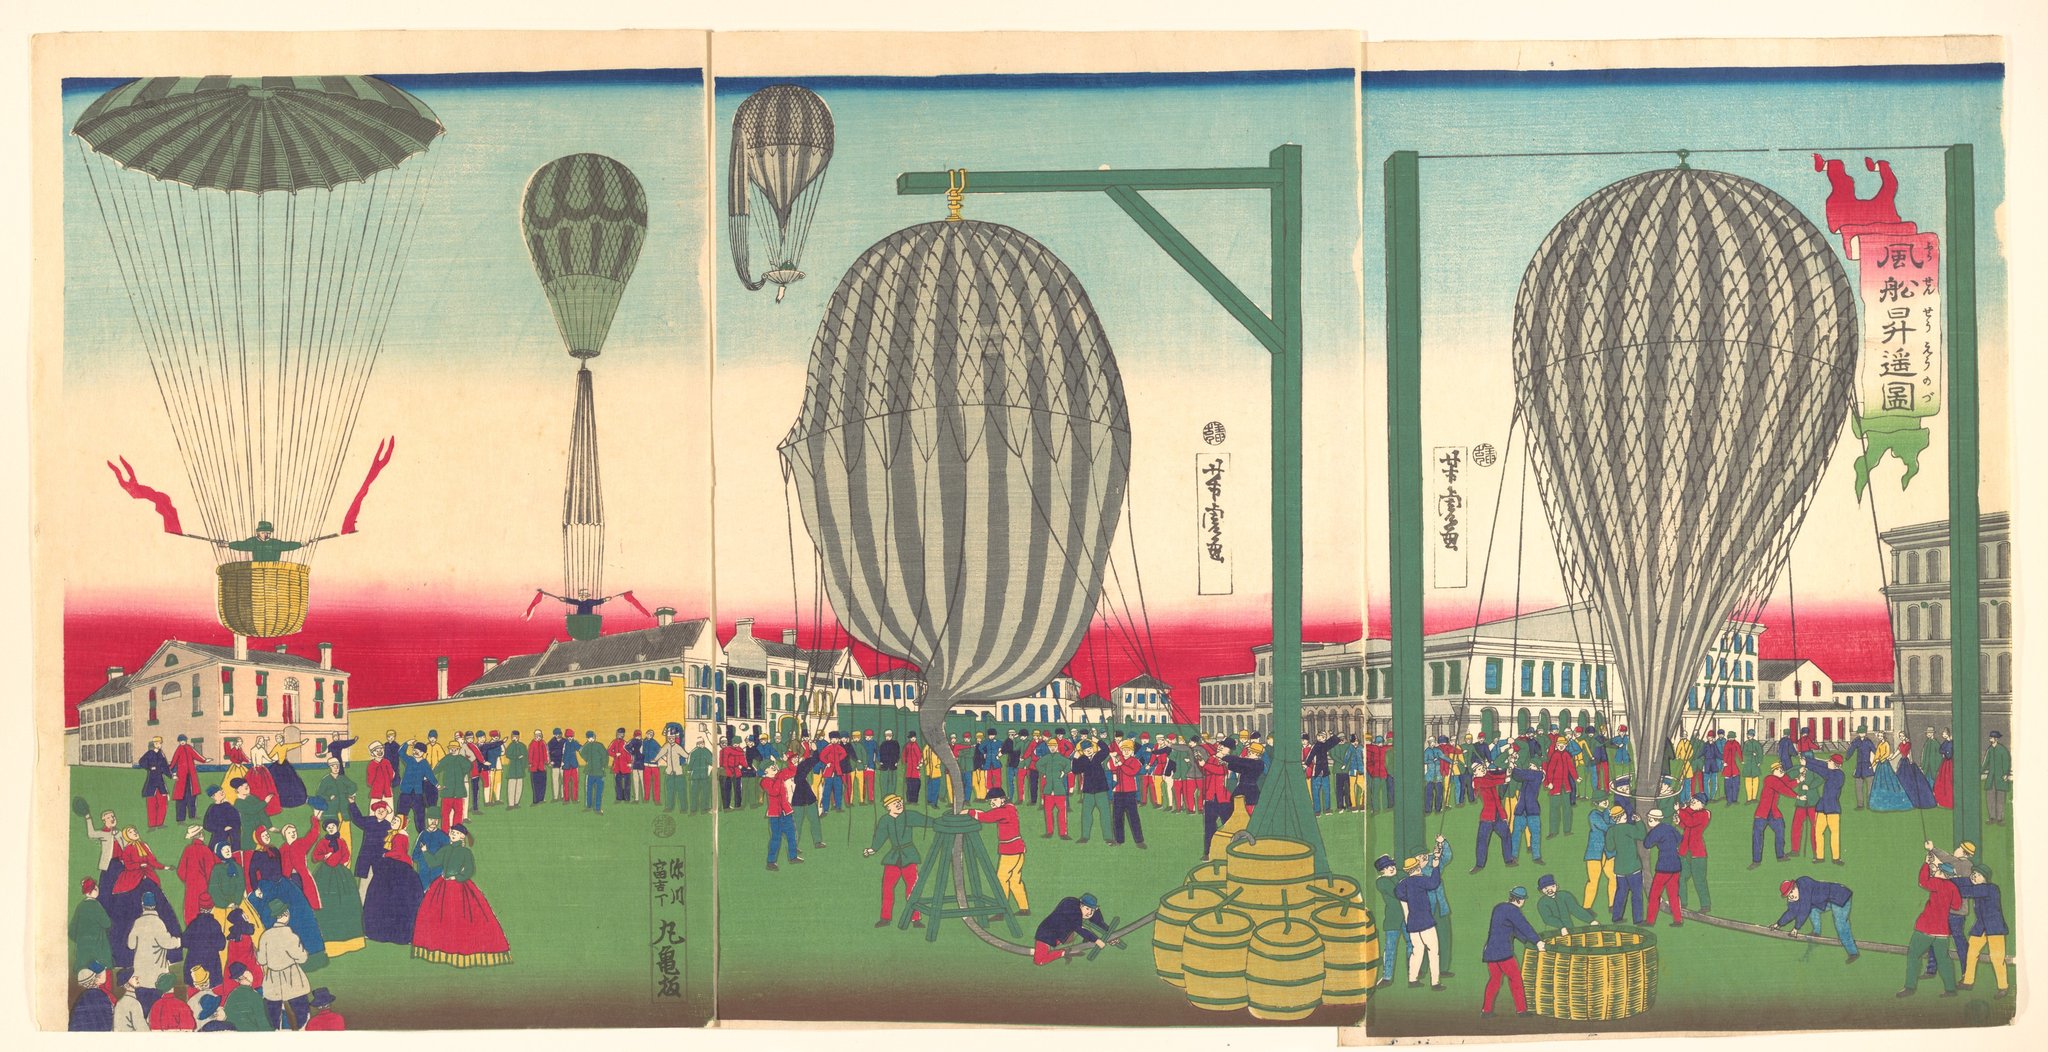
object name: print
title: Illustration of a Balloon Ascending (Fūsen shōyō no zu)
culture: japanese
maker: utagawa yoshitora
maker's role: artist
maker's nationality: japanese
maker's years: 1845-1880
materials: ink, paper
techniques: woodblock print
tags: crowd,hot air balloons